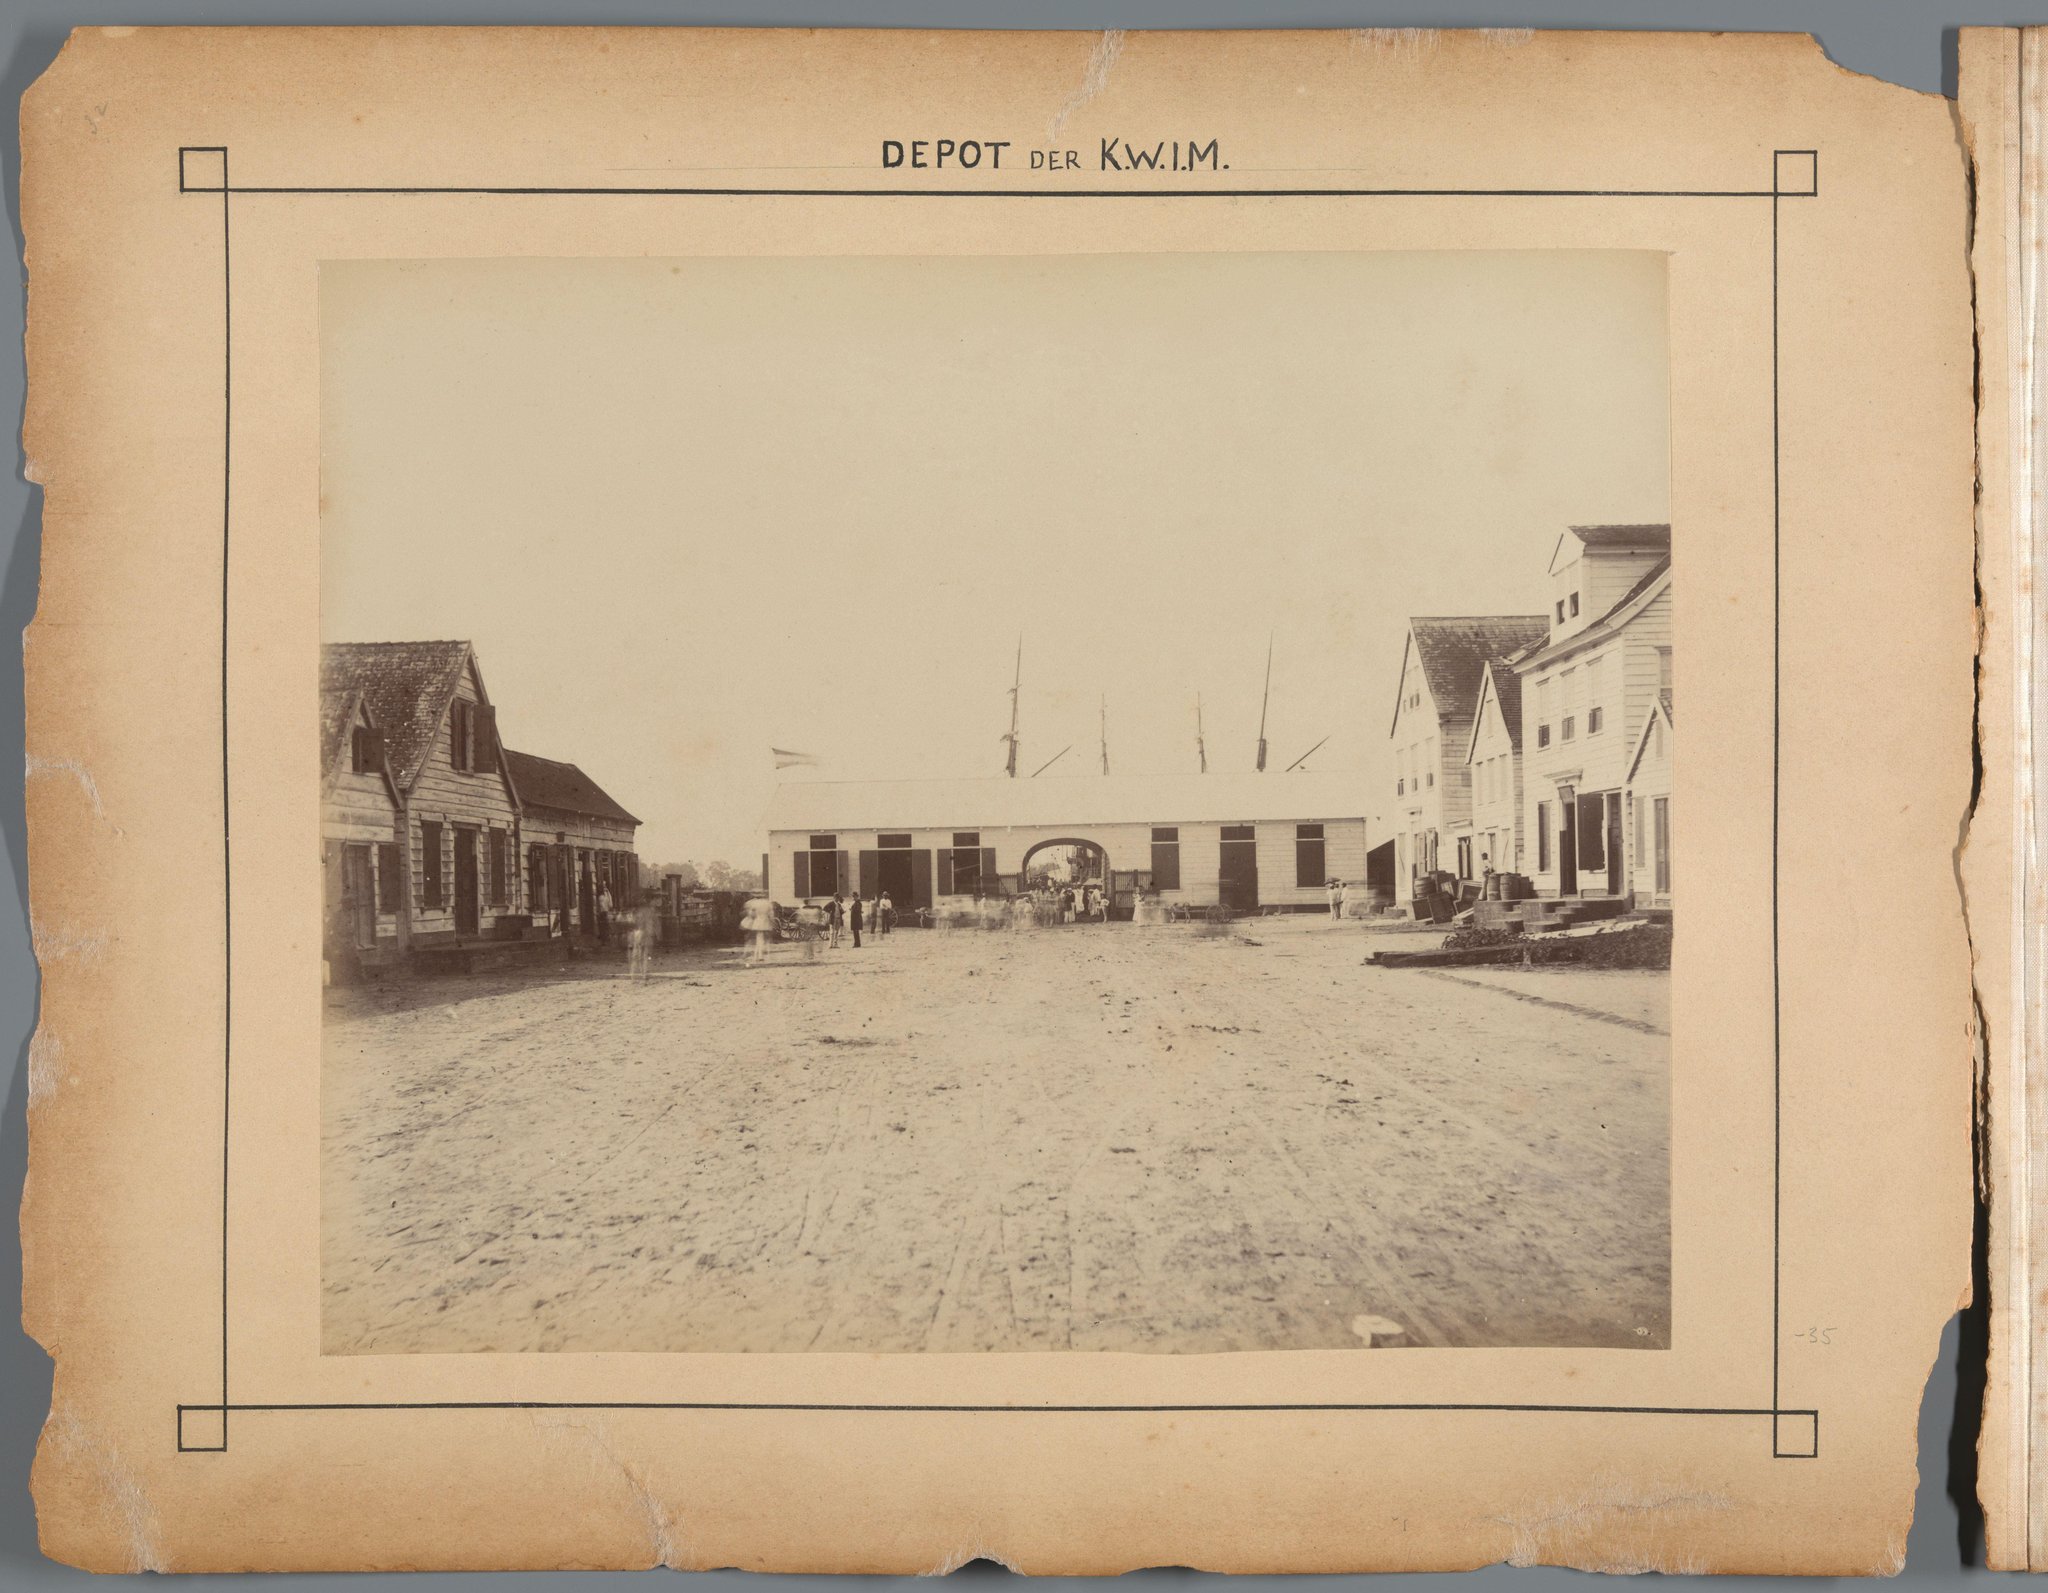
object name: photograph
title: Depot der K.W.I.M.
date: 1898-1902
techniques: albumen print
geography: suriname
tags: warehouse (~ harbour), suriname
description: Depot van de Koninklijke West-Indische Maildienst, Paramaribo.